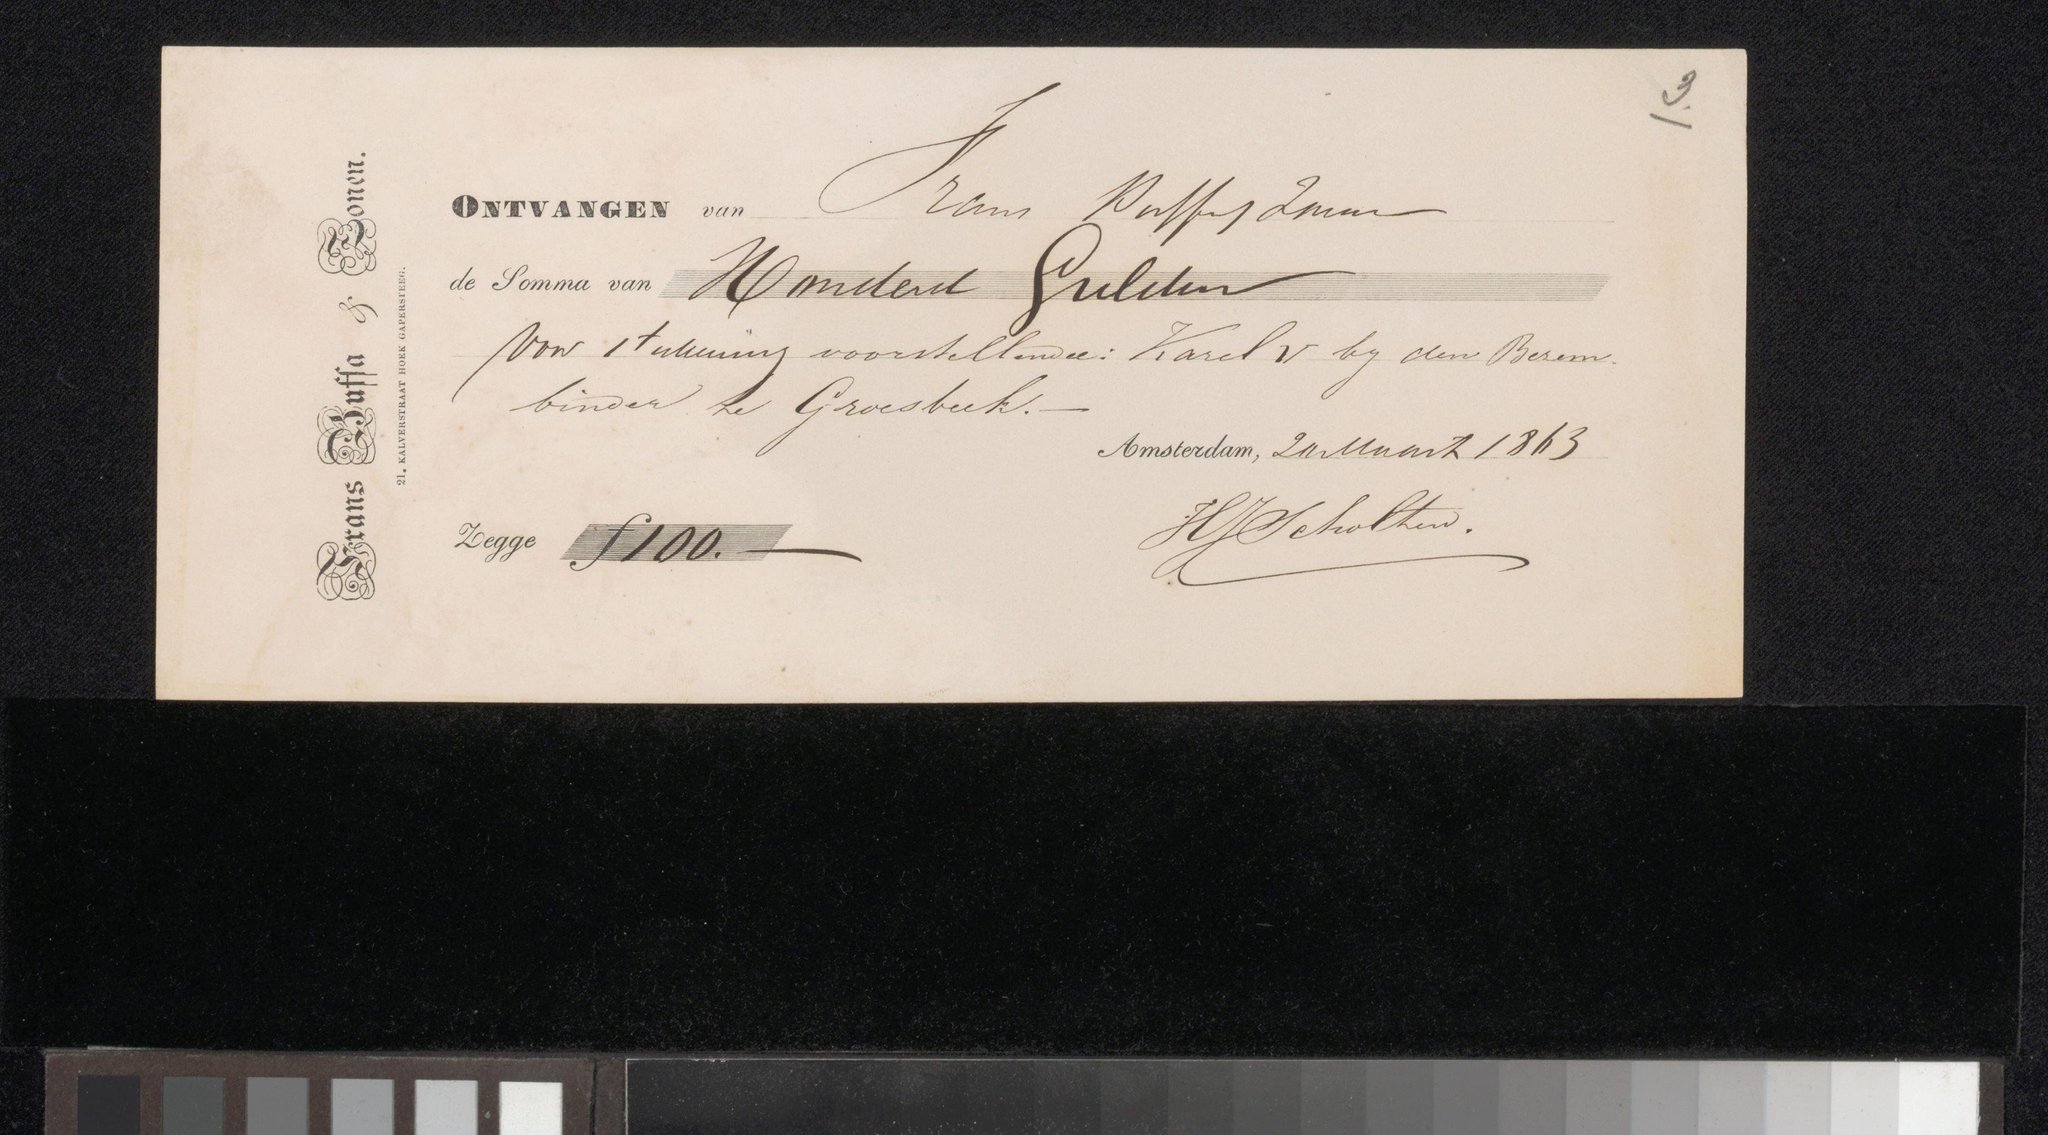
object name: ontvangstbewijs, kwitantie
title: Kwitantie voor Hendrik Jacobus Scholten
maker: hendrik jacobus scholten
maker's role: draughtsman, painter, print maker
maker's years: 1824-1907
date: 1863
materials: ink, paper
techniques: pen, printing, writing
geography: amsterdam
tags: drawing, money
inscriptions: collector's mark: Lugt 2233